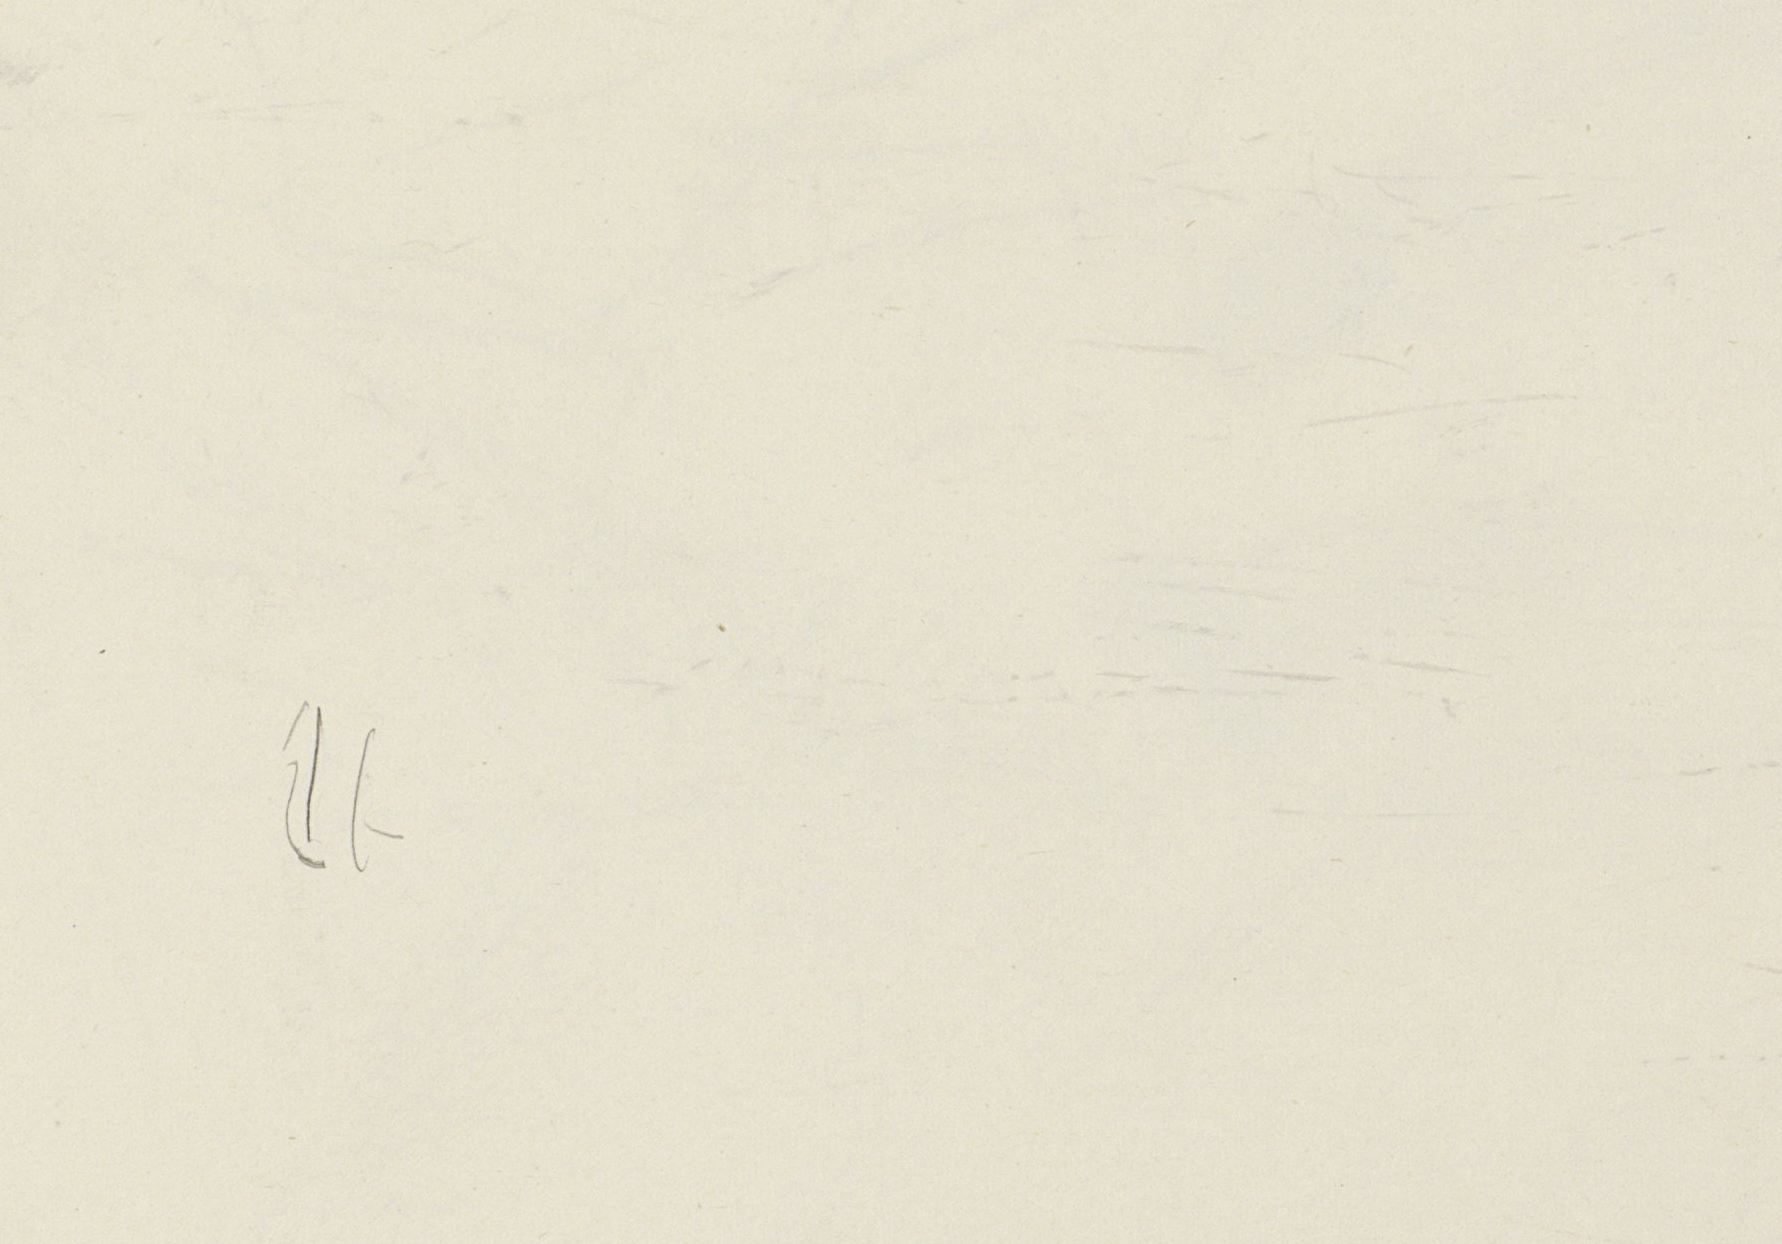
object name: sketchbook leaf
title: Studie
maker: isaac israels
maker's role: draughtsman, painter, print maker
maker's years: 1865-1934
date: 1915-1934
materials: paper, pencil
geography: the hague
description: Blad 1 verso uit schetsboek XXV met 23 bladen.